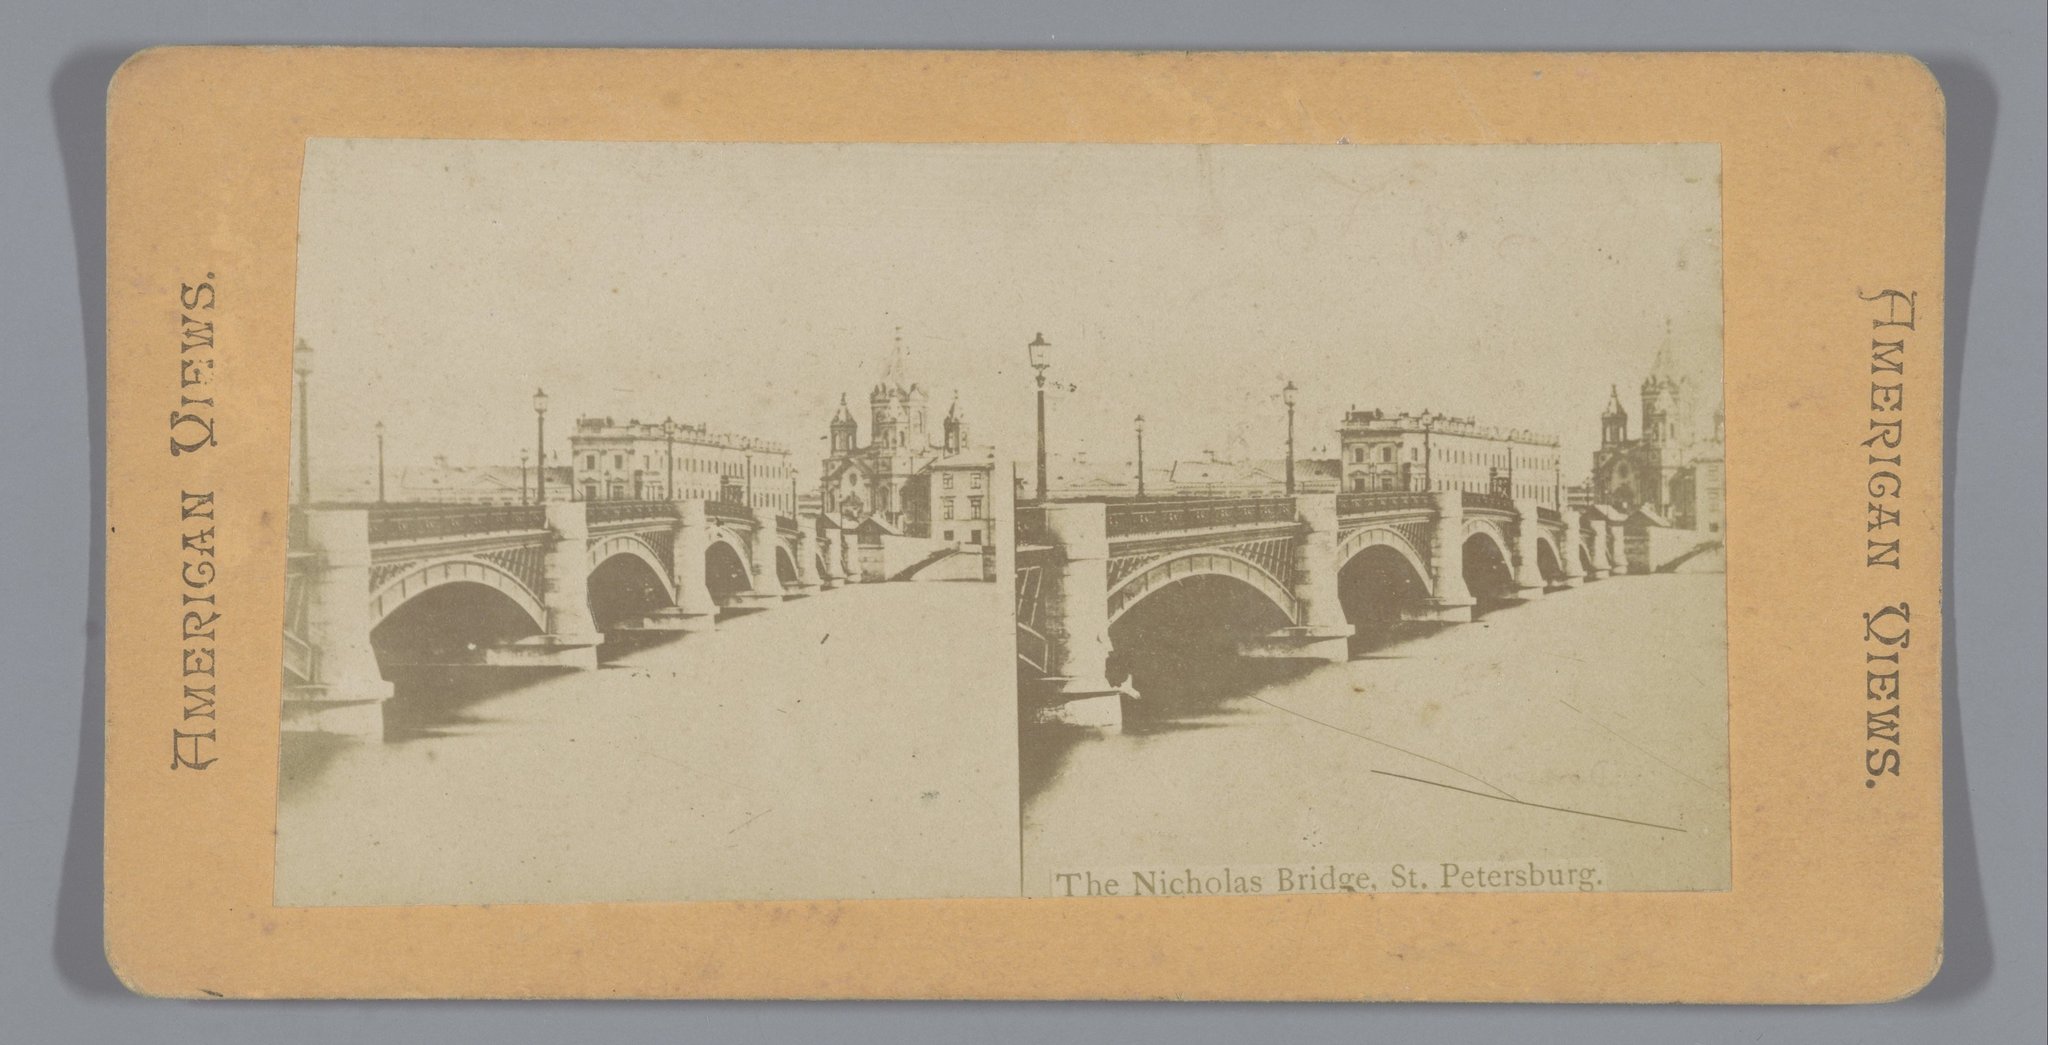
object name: stereograph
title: Gezicht op de Nicolaasbrug in Sint-Petersburg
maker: Anonymous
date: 1850-1880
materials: cardboard, photographic support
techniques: albumen print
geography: sint-petersburg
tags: bridge in village across river, canal, etc.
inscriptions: inscription: ‘American Views.’